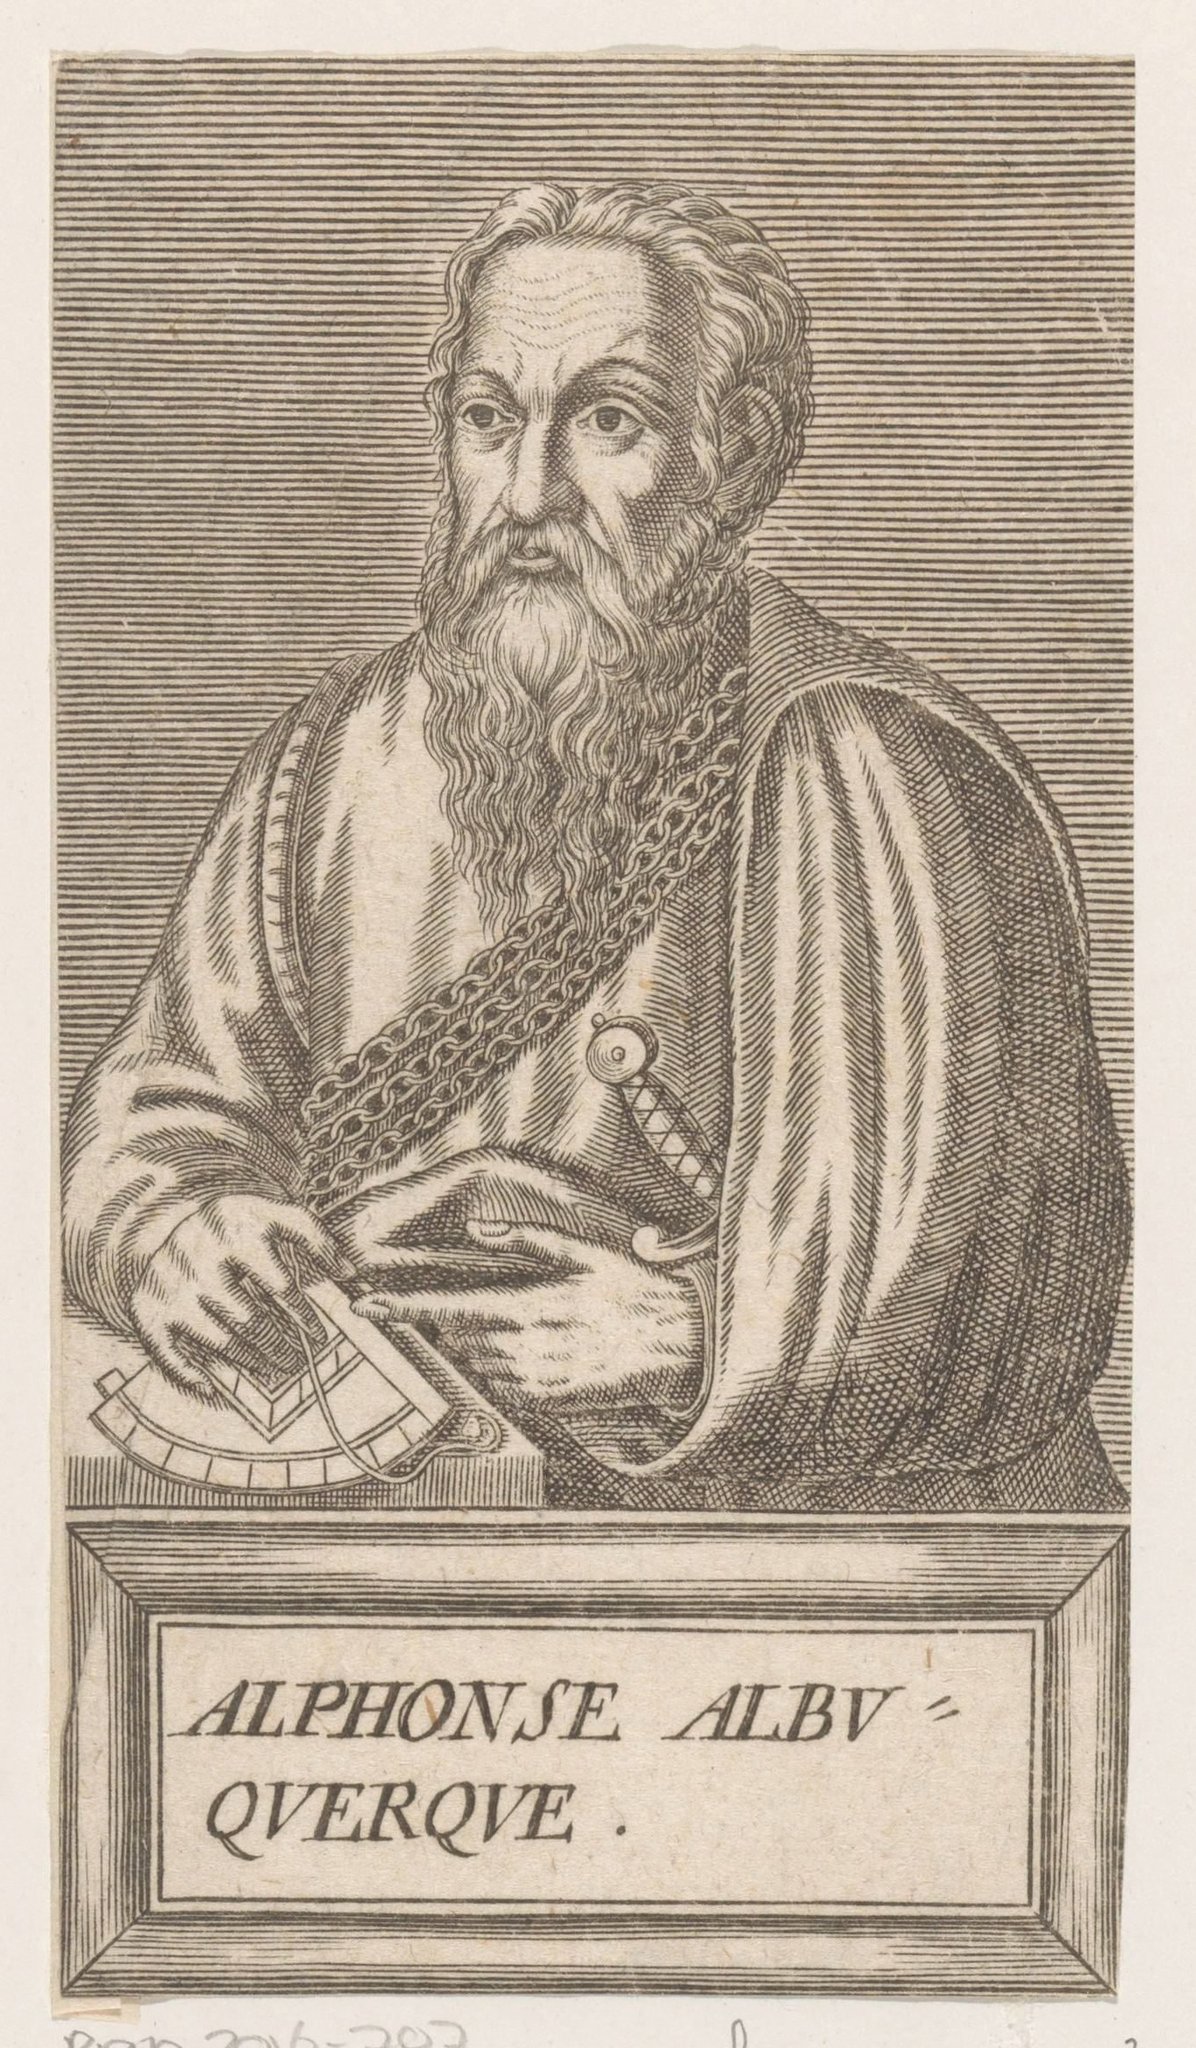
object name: print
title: Portret van Afonso de Albuquerque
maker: Anonymous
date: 1600-1699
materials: paper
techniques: engraving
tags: zeevaarder, afonso de albuquerque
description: Portret van Afonso de Albuquerque. In een kader zijn naam.